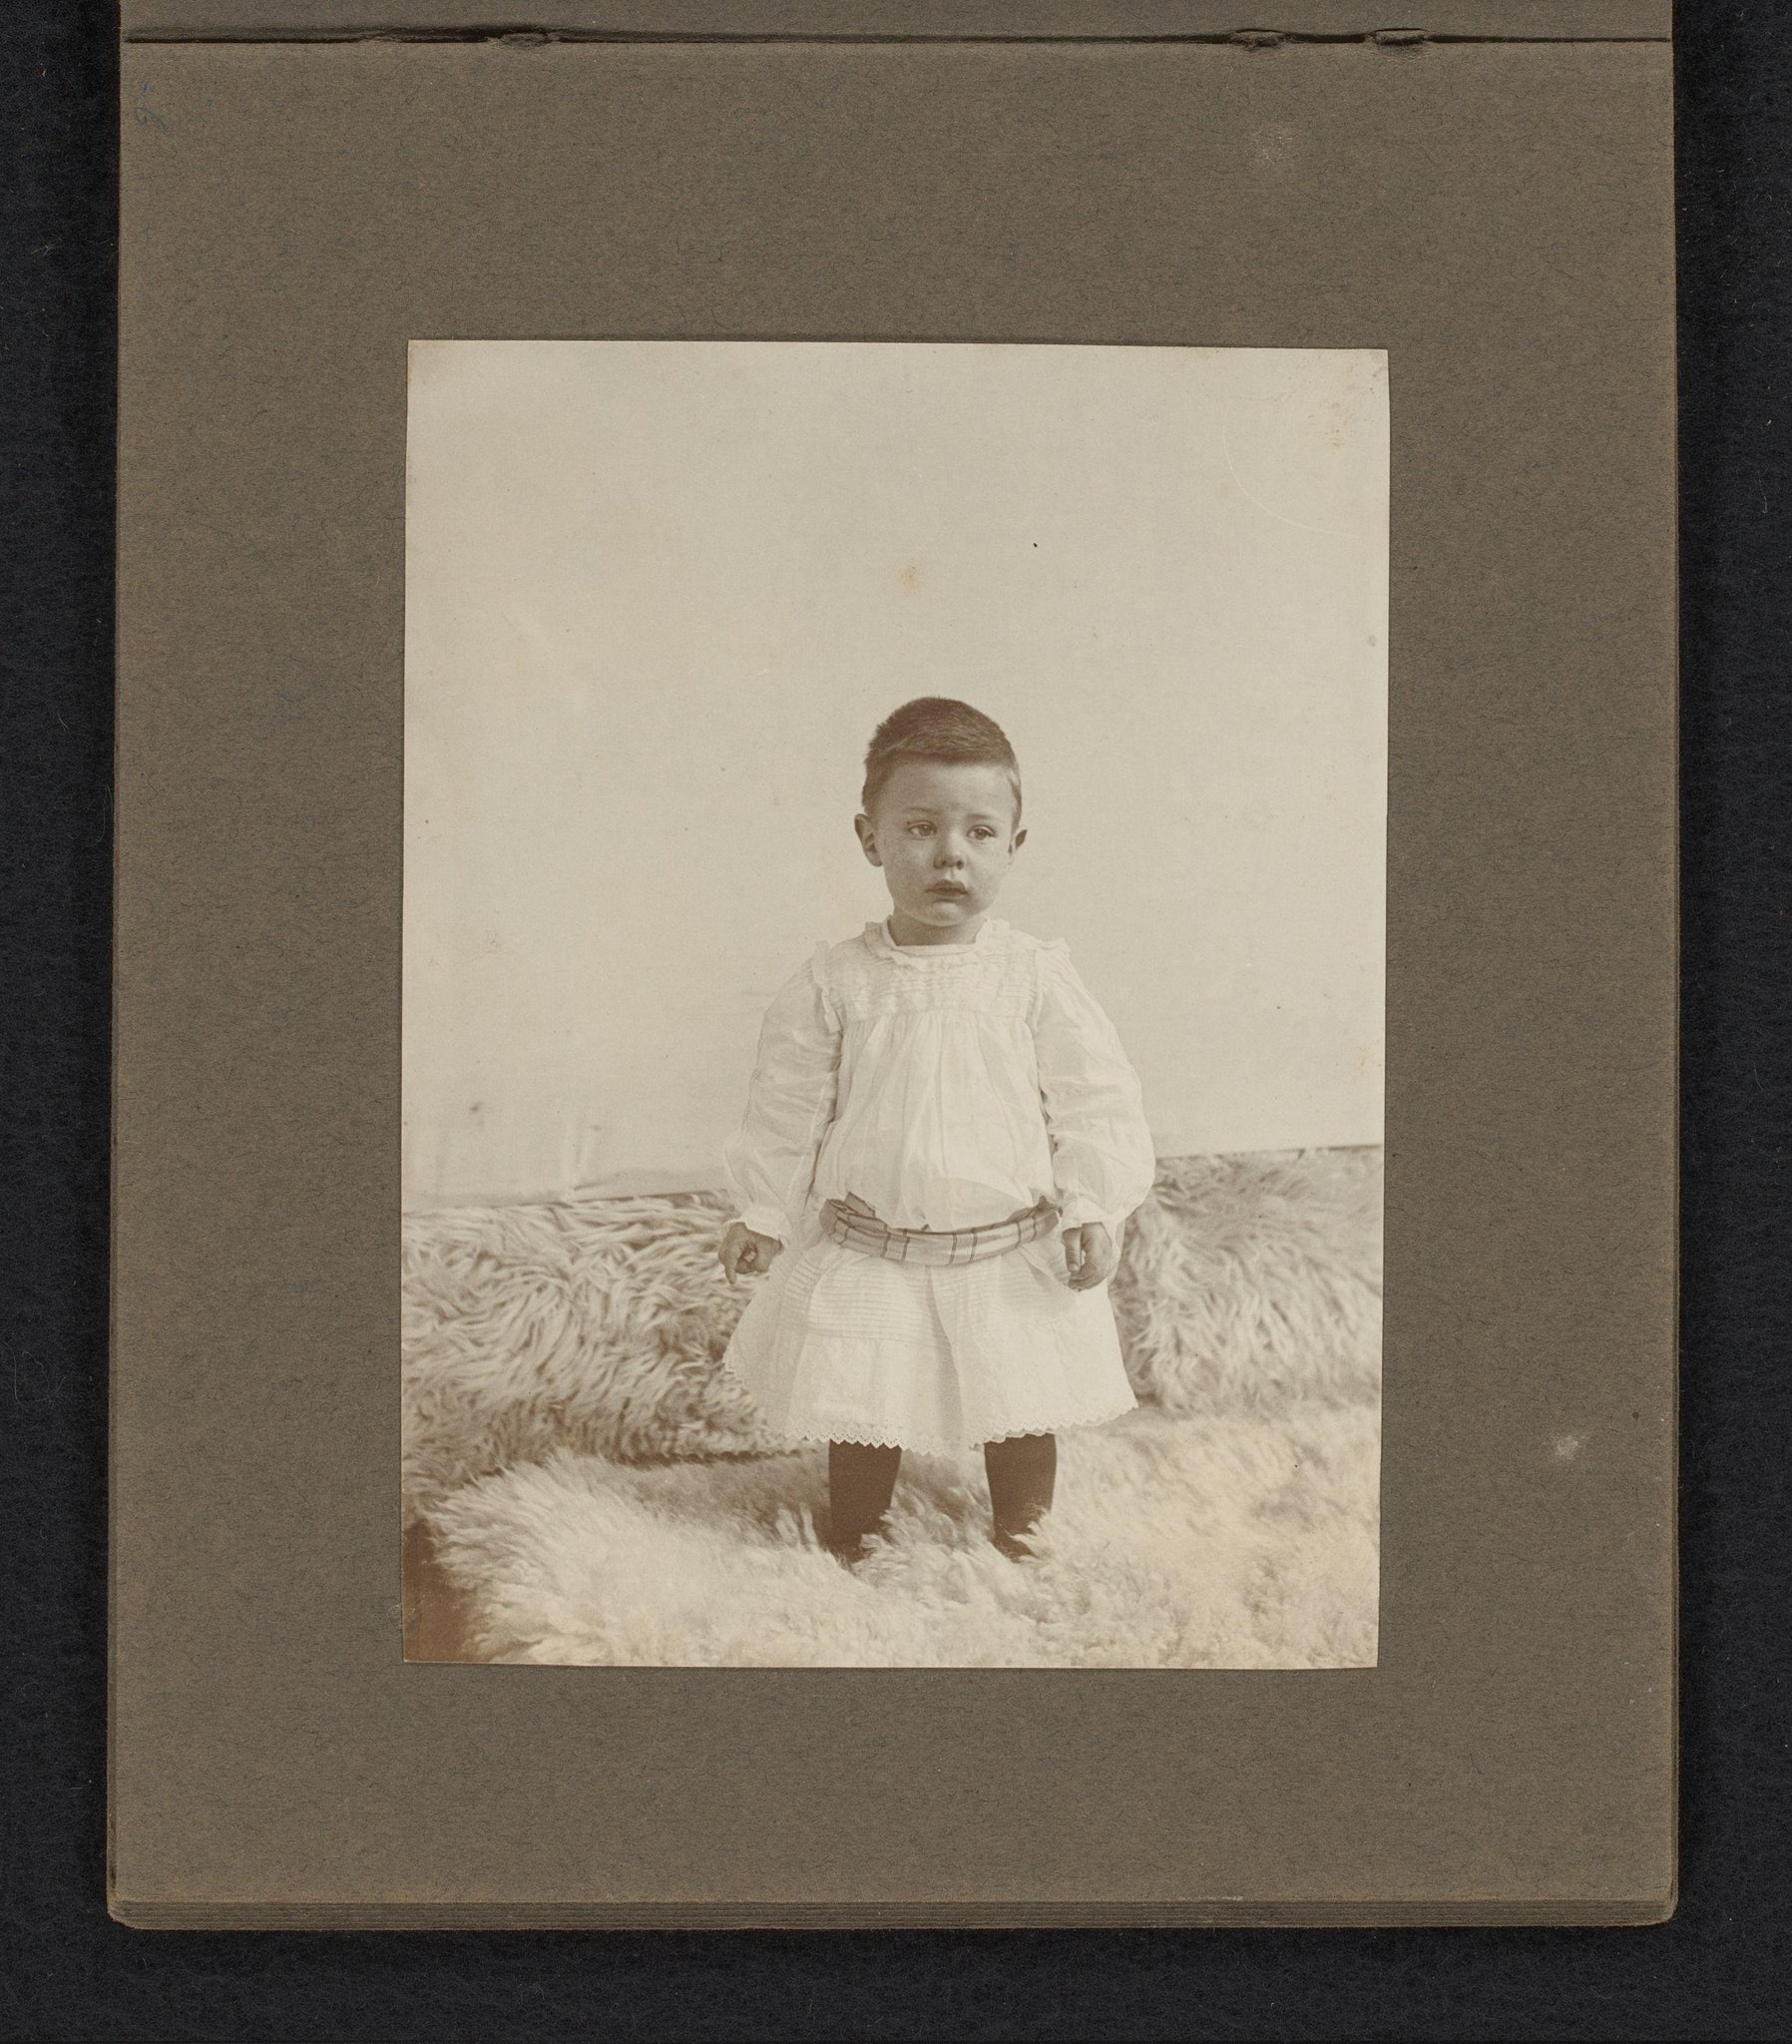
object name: photograph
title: Carel van den Berg als peuter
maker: hendrik herman van den berg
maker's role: amateurfotograaf, jurist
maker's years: 1875-1944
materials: paper, cardboard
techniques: gelatin silver print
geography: amsterdam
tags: carel frederik van den berg (cay), toddler (male)